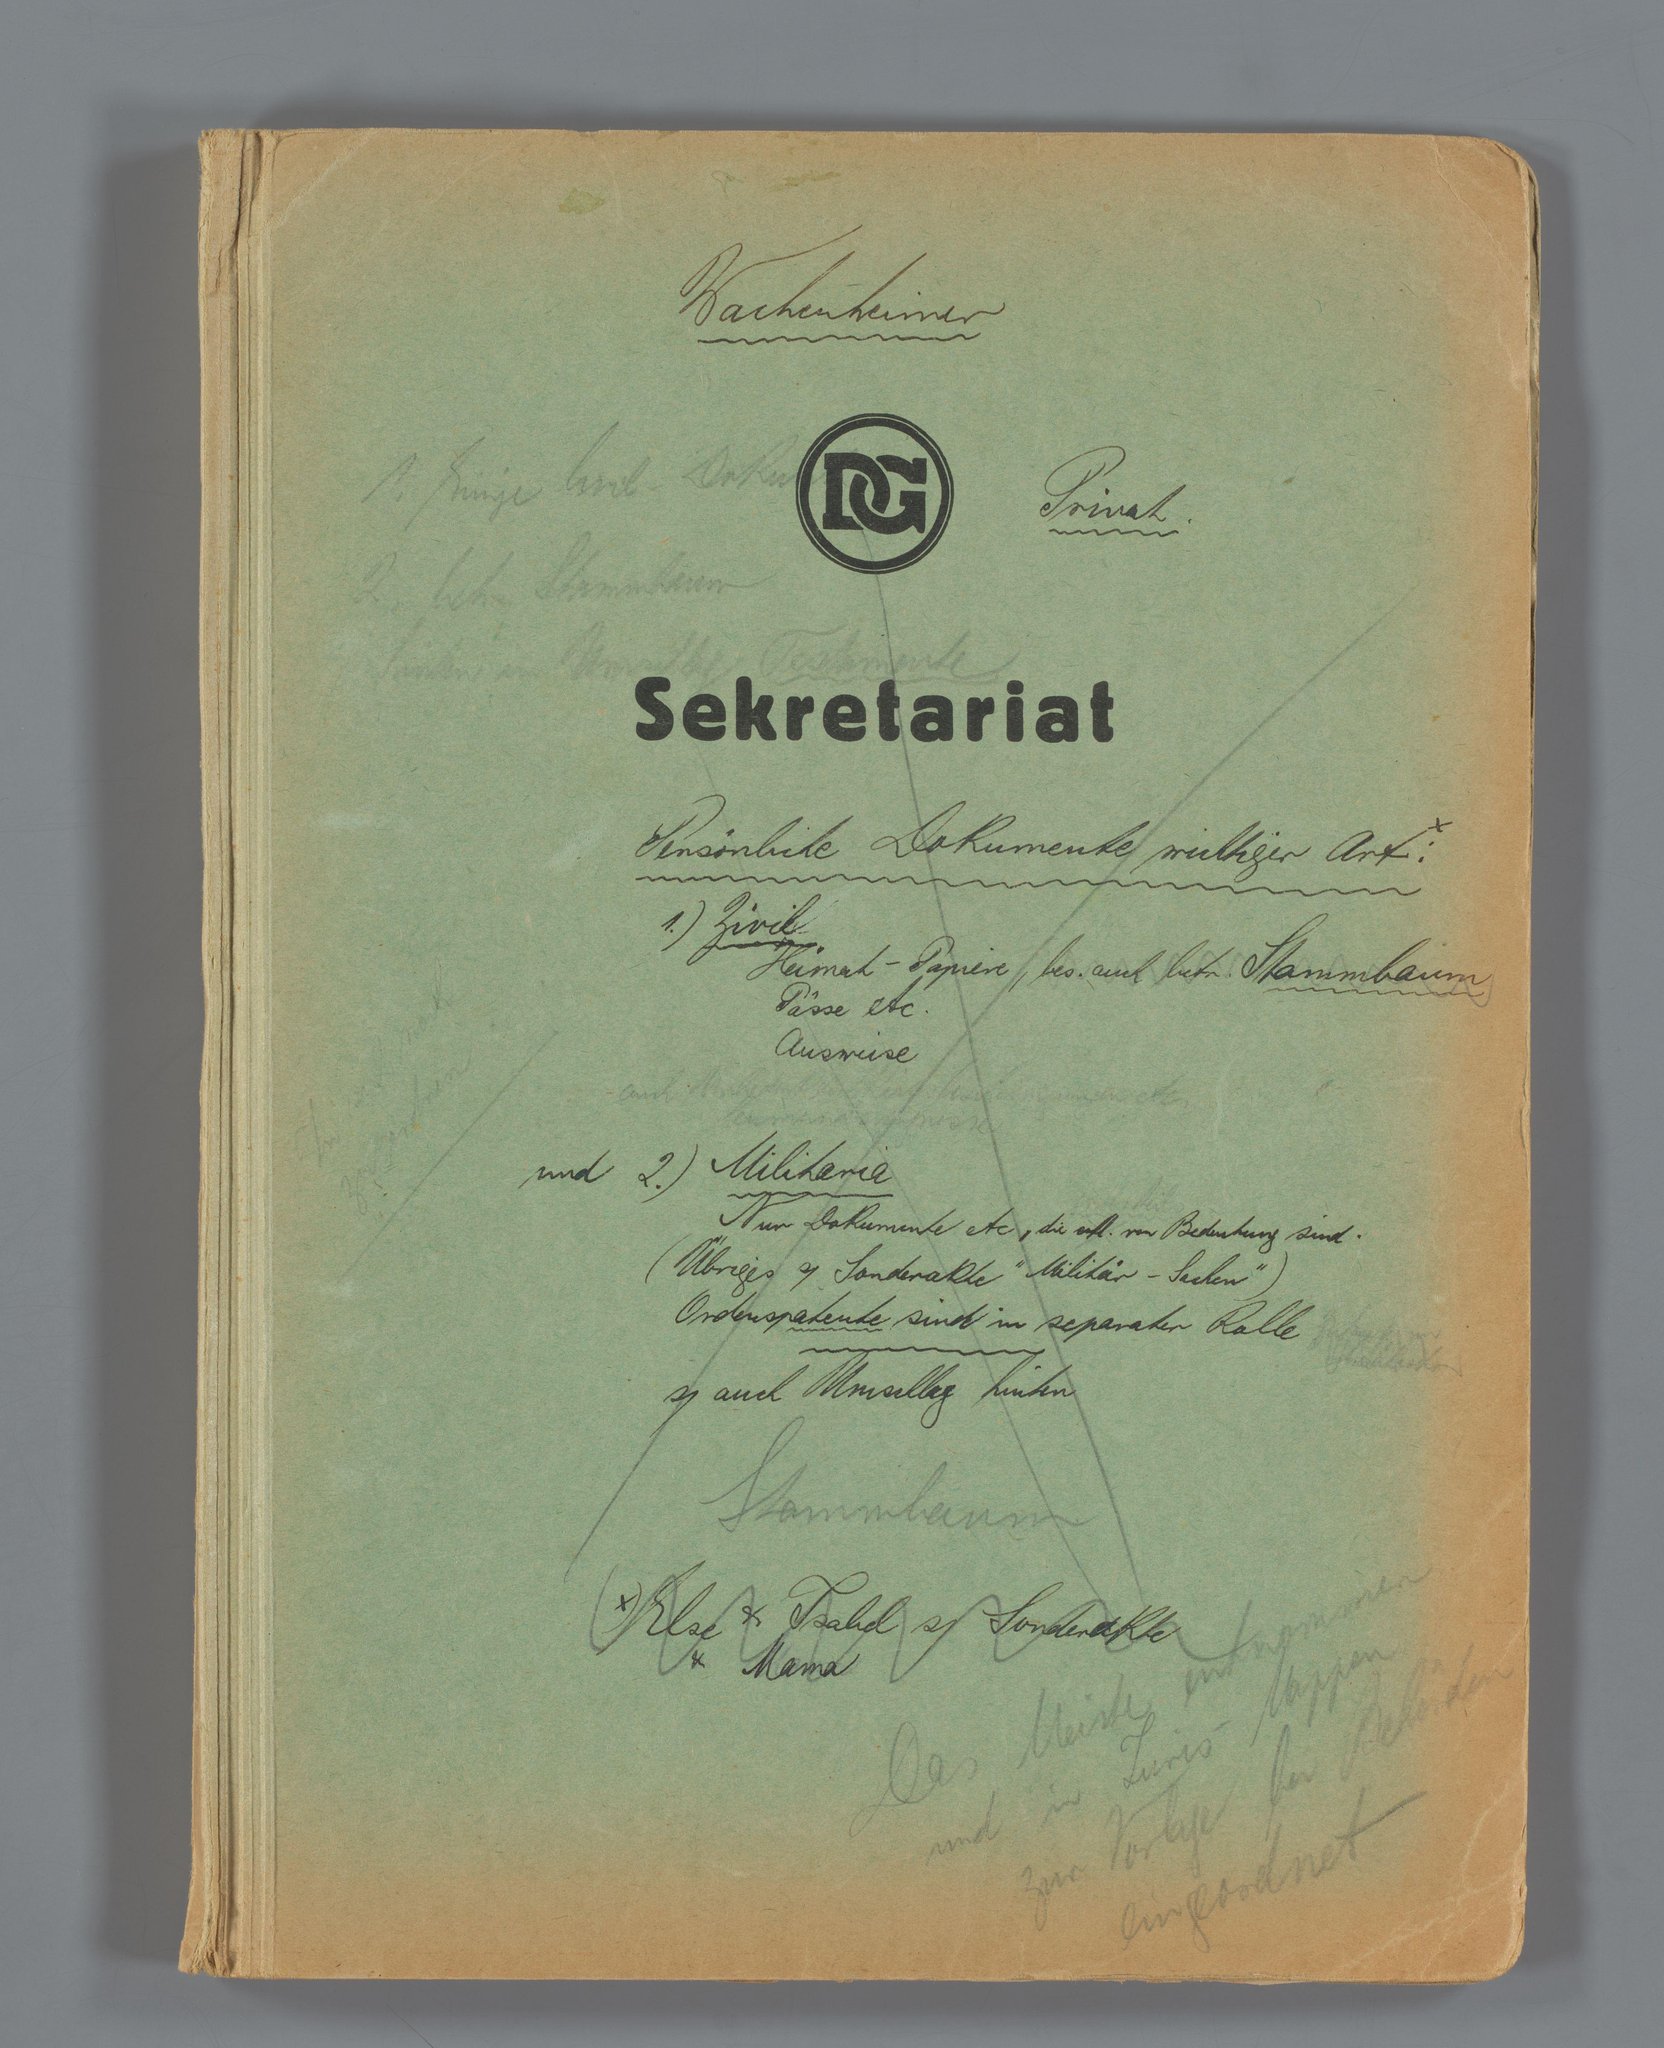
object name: document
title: Officiele documenten uit de levens van Else en Eugen Wachenheimer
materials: paper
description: Dit object is onderdeel van de nalatenschap van Isabel Elon-Wachenheimer (1928-2010). Tot haar overlijden behoorde het samen met de andere objecten uit de nalatenschap tot haar privédomein van Isabel Wachenheimer. In die particuliere context zijn deze objecten tezamen en individueel aandenkens - aan de jeugd, ouders en familie van Isabel Wachenheimer vóór en tijdens de Shoah en aan haar leven na de Tweede Wereldoorlog. Isabel Wachenheimer, die van juni 1943 tot mei 1945 gevangen zat in Kamp Westerbork, Theresienstadt, Auschwitz, Lenzing a/d Oberdonau (een buitenkamp van Mauthausen), overleefde de Shoah. Haar ouders – Eugène Wachenheimer en Else Wachenheimer-Moos - werden op 14 oktober 1944 in Auschwitz-Birkenau vermoord.